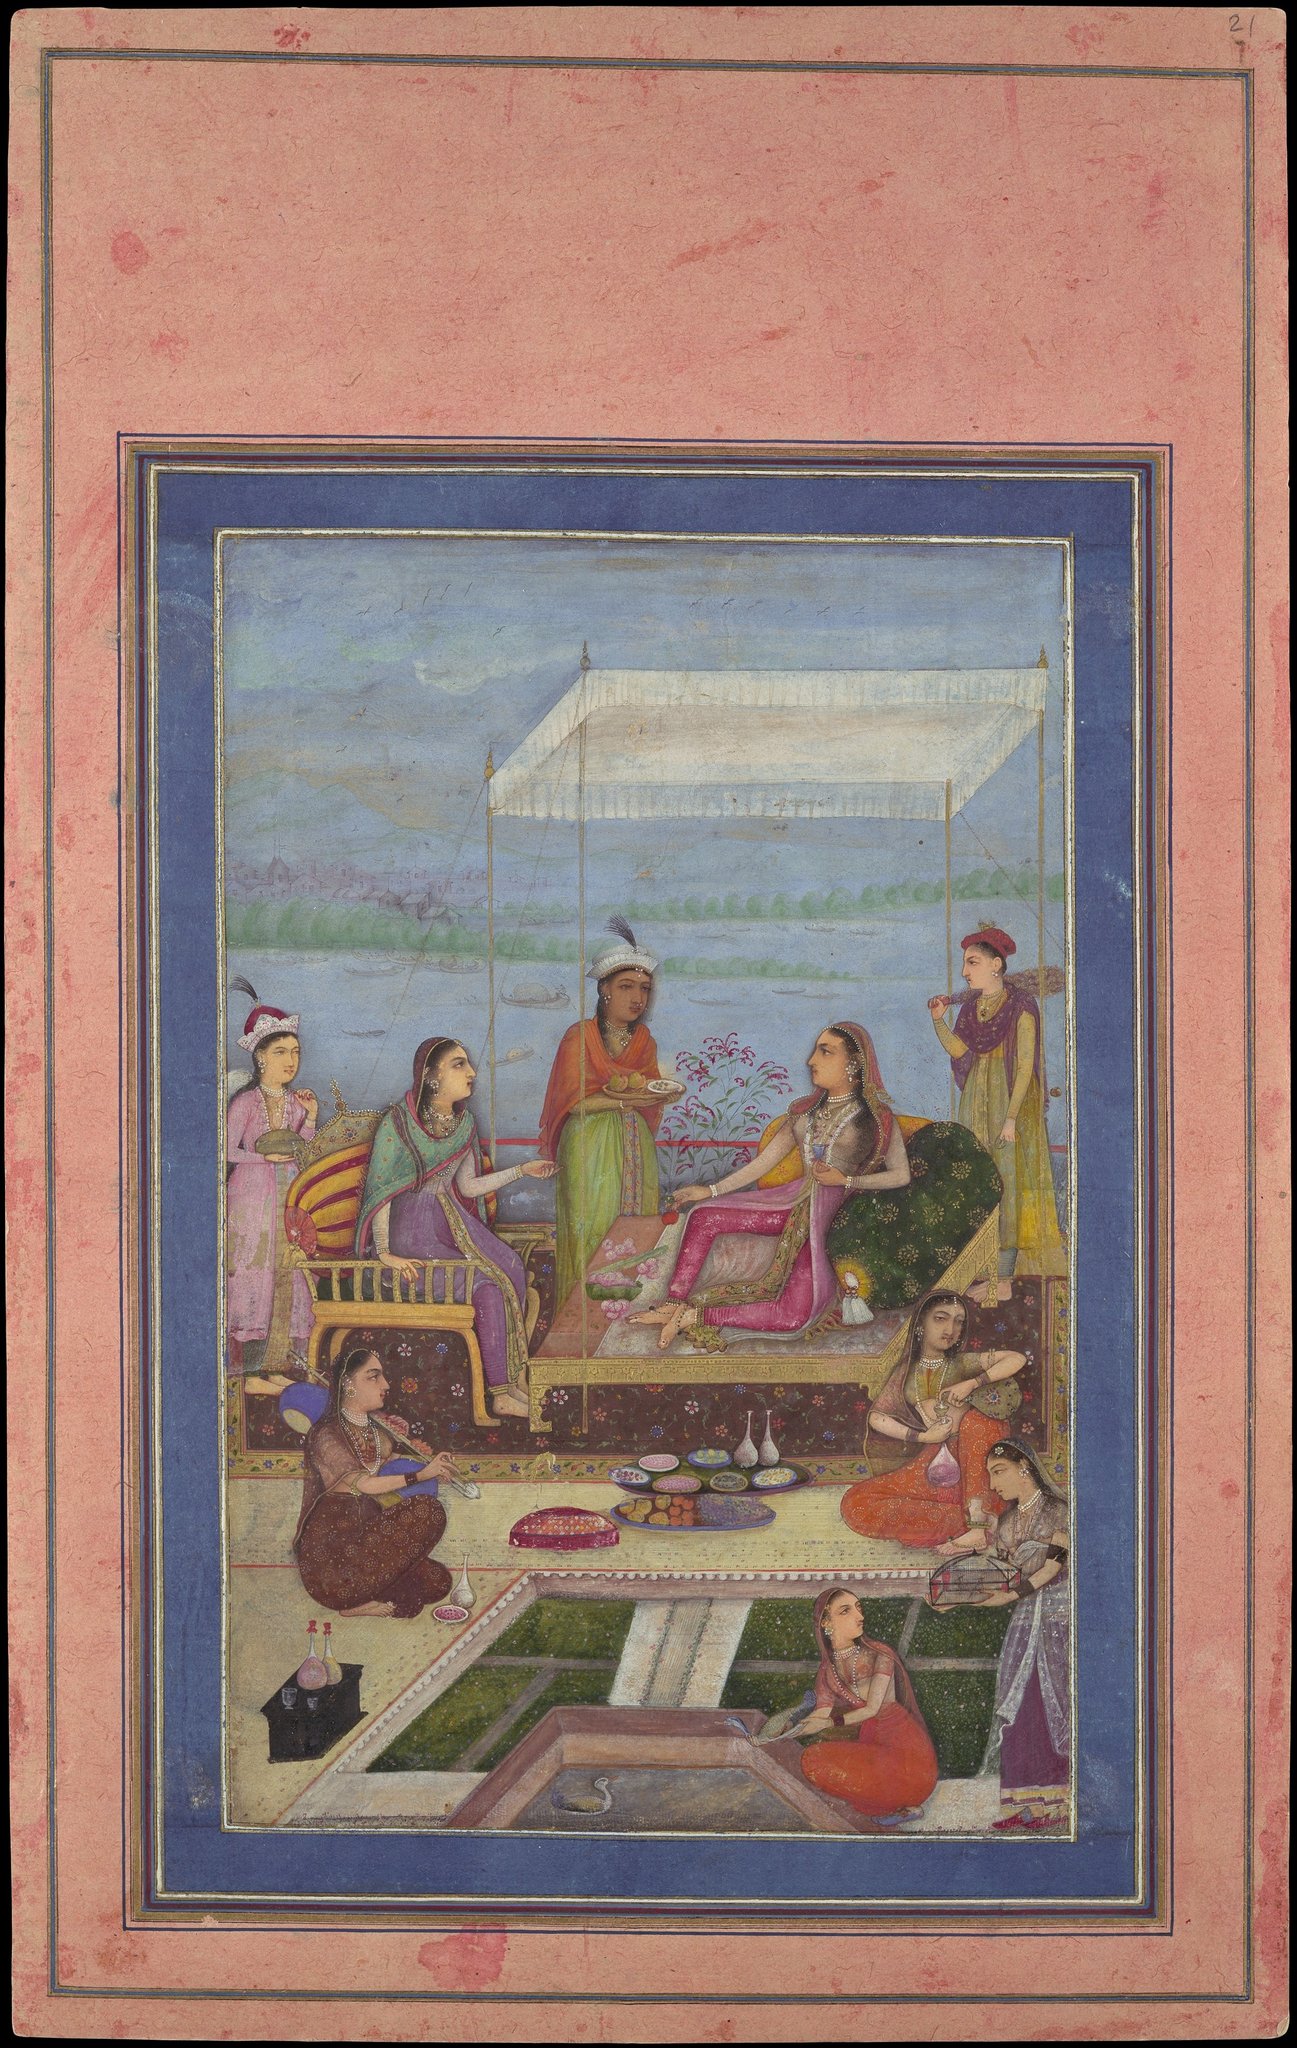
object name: illustrated album leaf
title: "Princess Entertaining a Visitor on the Balcony", Folio from the Davis Album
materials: gold, ink, paper, watercolor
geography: india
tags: food,musical instruments,princesses,women